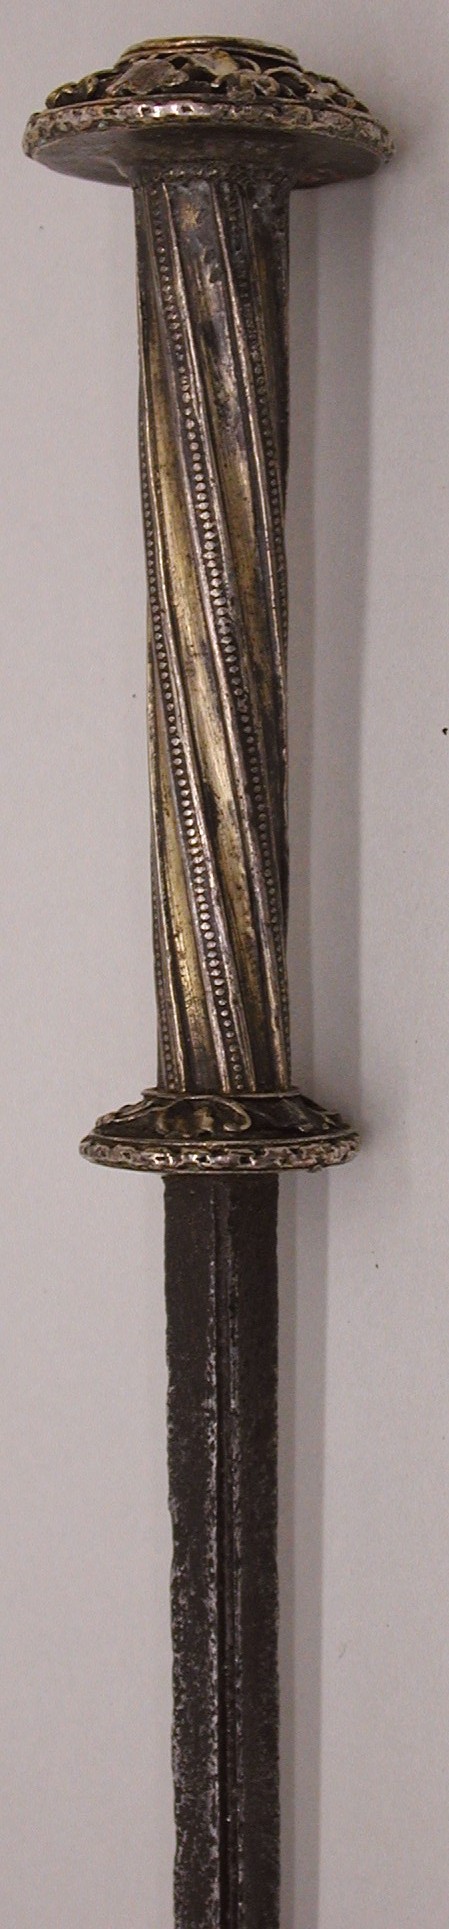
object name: dagger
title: Dagger in Gothic Style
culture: french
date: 1880-1890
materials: brass, enamel, steel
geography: france